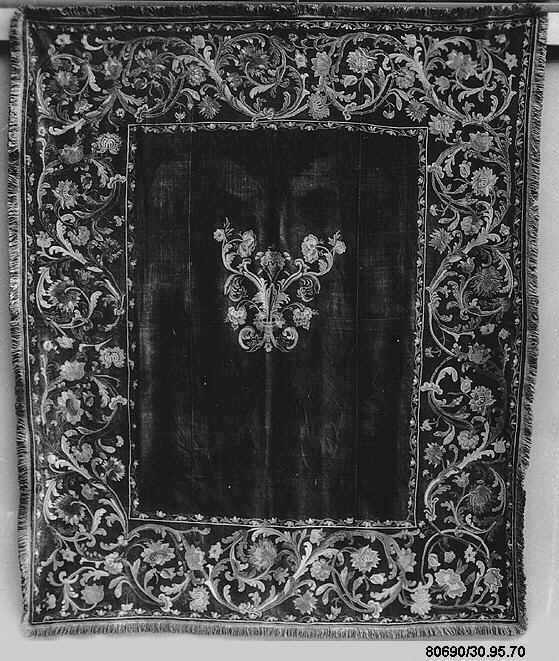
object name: cover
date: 1701-1800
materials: silk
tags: flowers